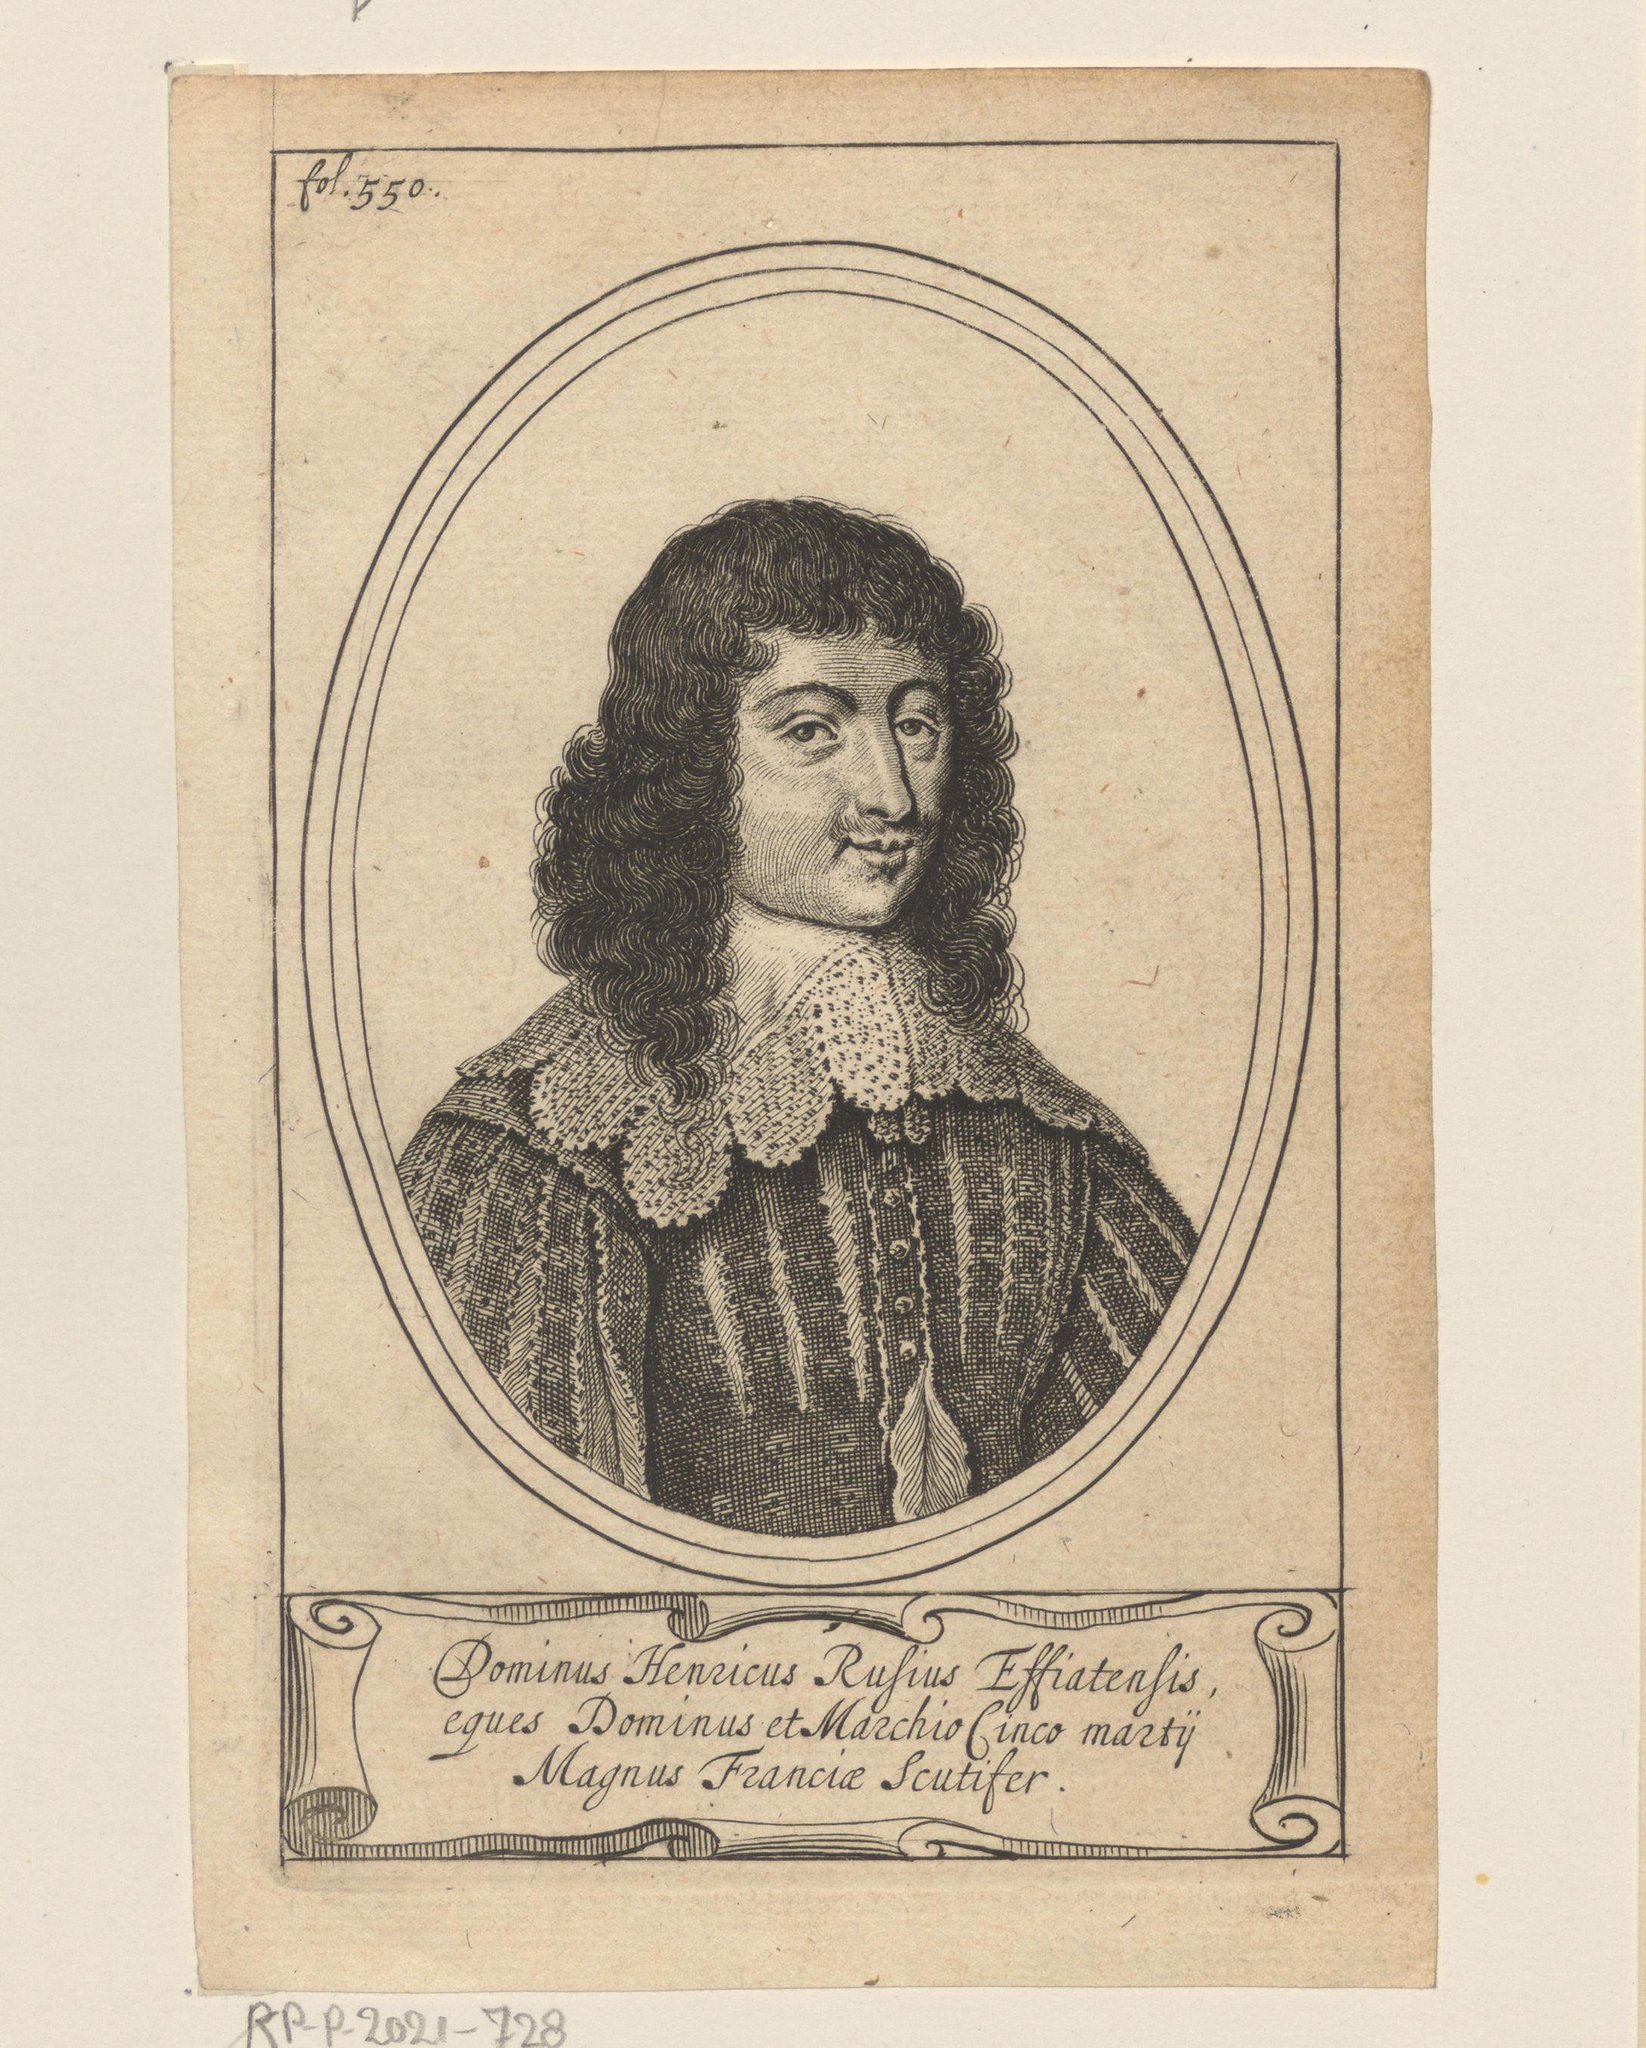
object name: print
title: Portret van Henri Coiffier de Ruzé, markies van Cinq-Mars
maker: Anonymous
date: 1650-1660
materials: paper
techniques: engraving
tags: historical persons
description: Eerdere staat gebruikt in: Bos, Lambert van den. Het treur-toneel der doorluchtige mannen. Amsterdam: Nicolaes van Ravesteyn, 1650, dl. 1.